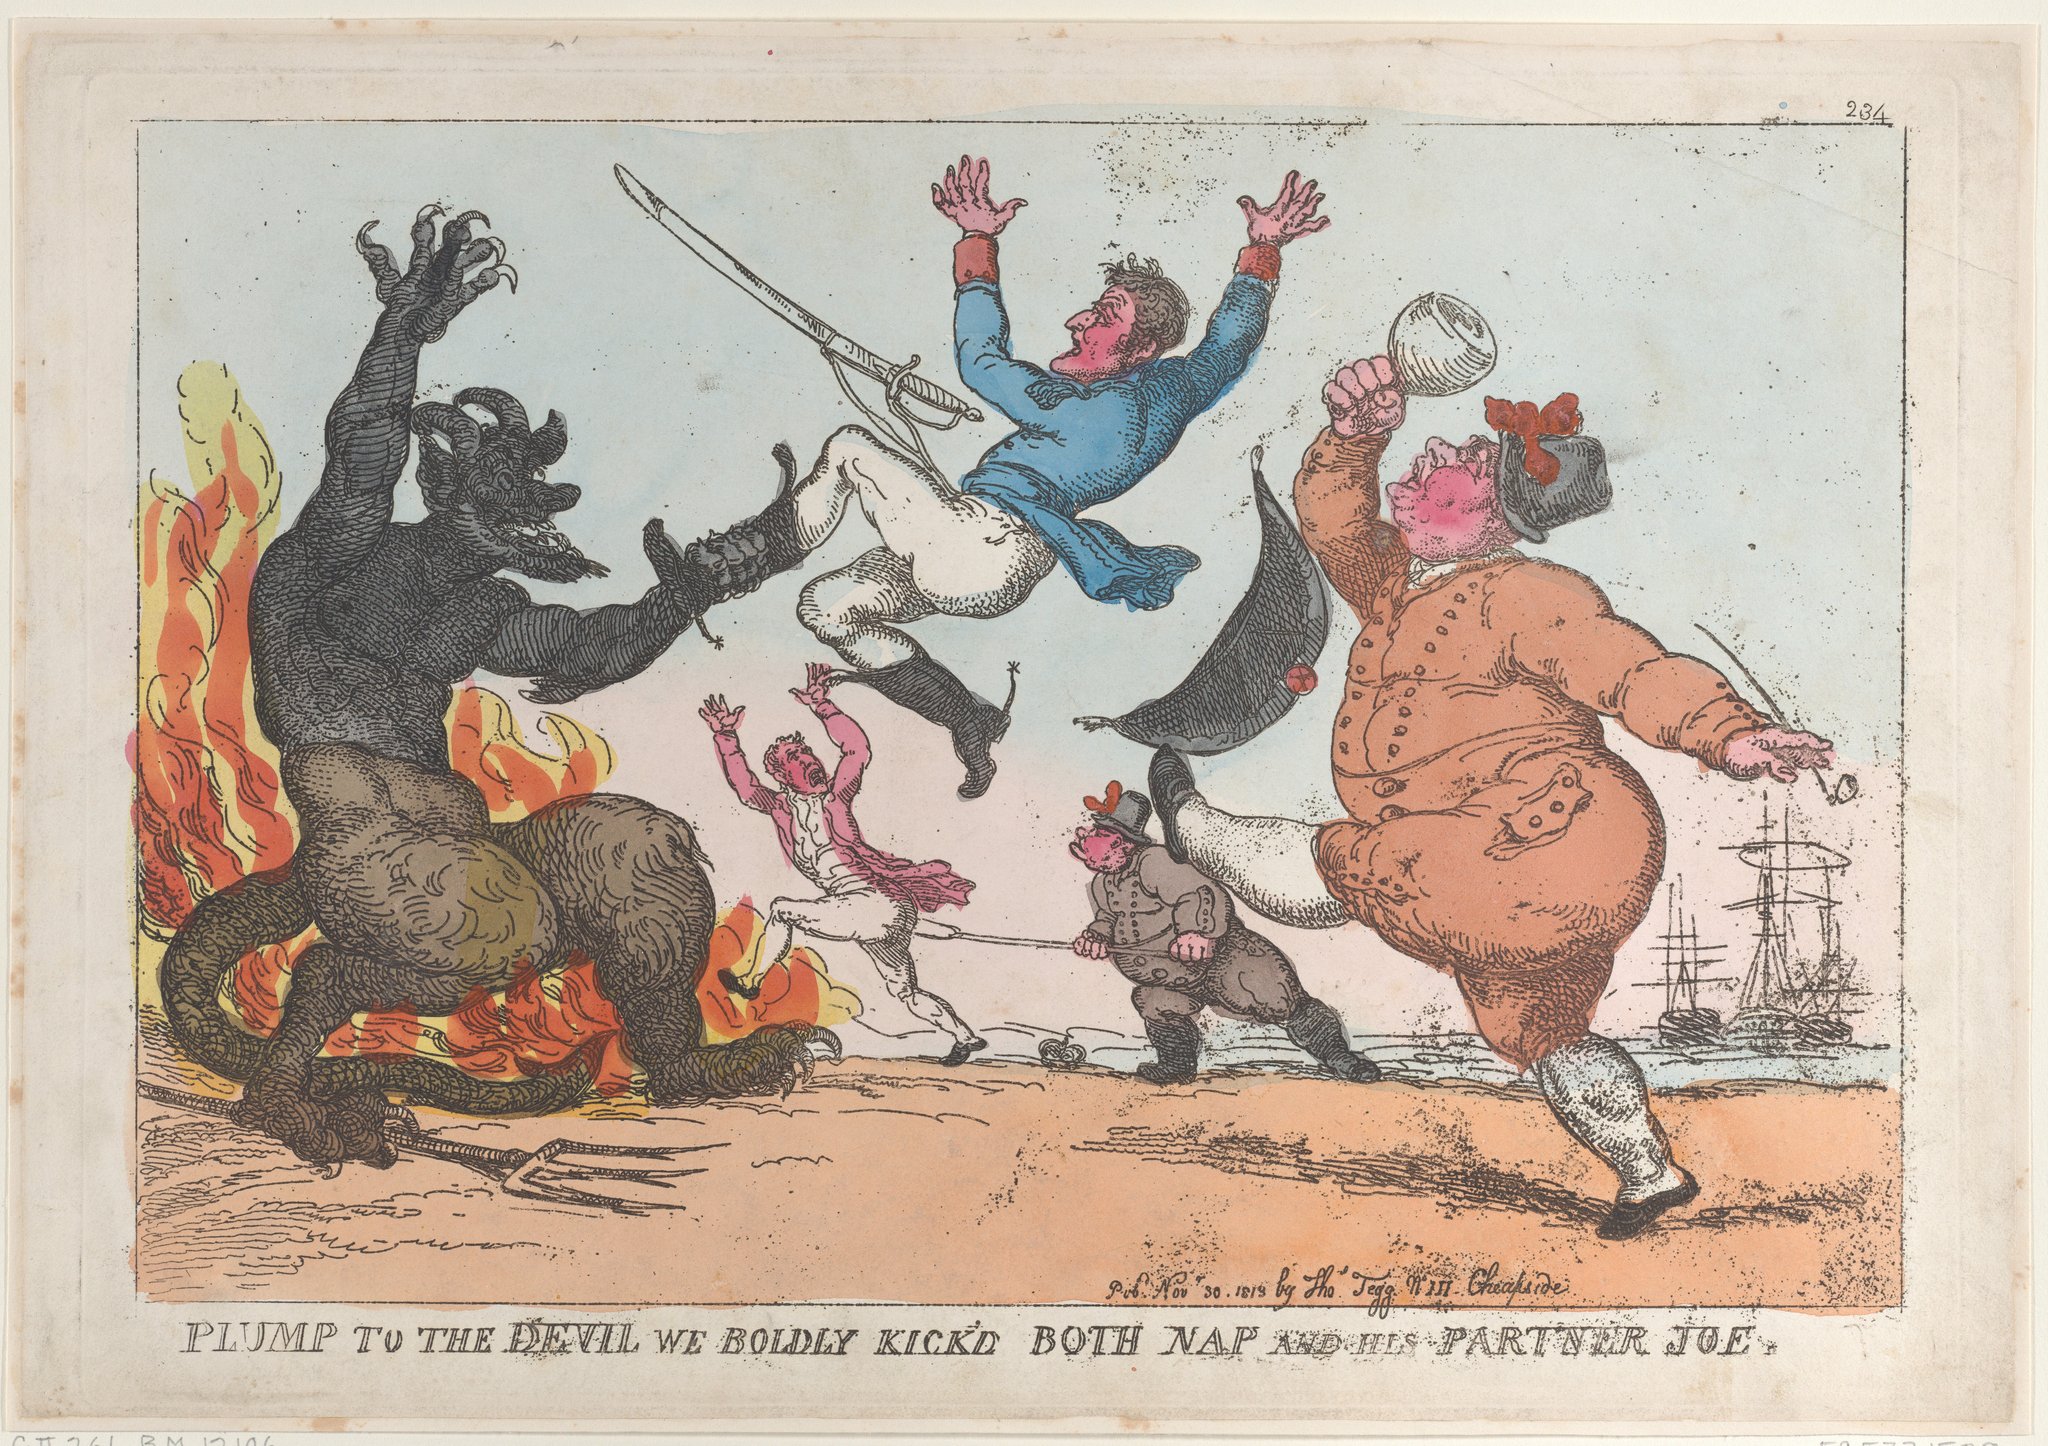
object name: print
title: Plump to the Devil We Boldly Kick'd Both Nap and His Partner Joe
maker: thomas rowlandson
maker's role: artist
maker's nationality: british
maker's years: 1757-1827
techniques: etching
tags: satire,napoleon i,men,devil,politics